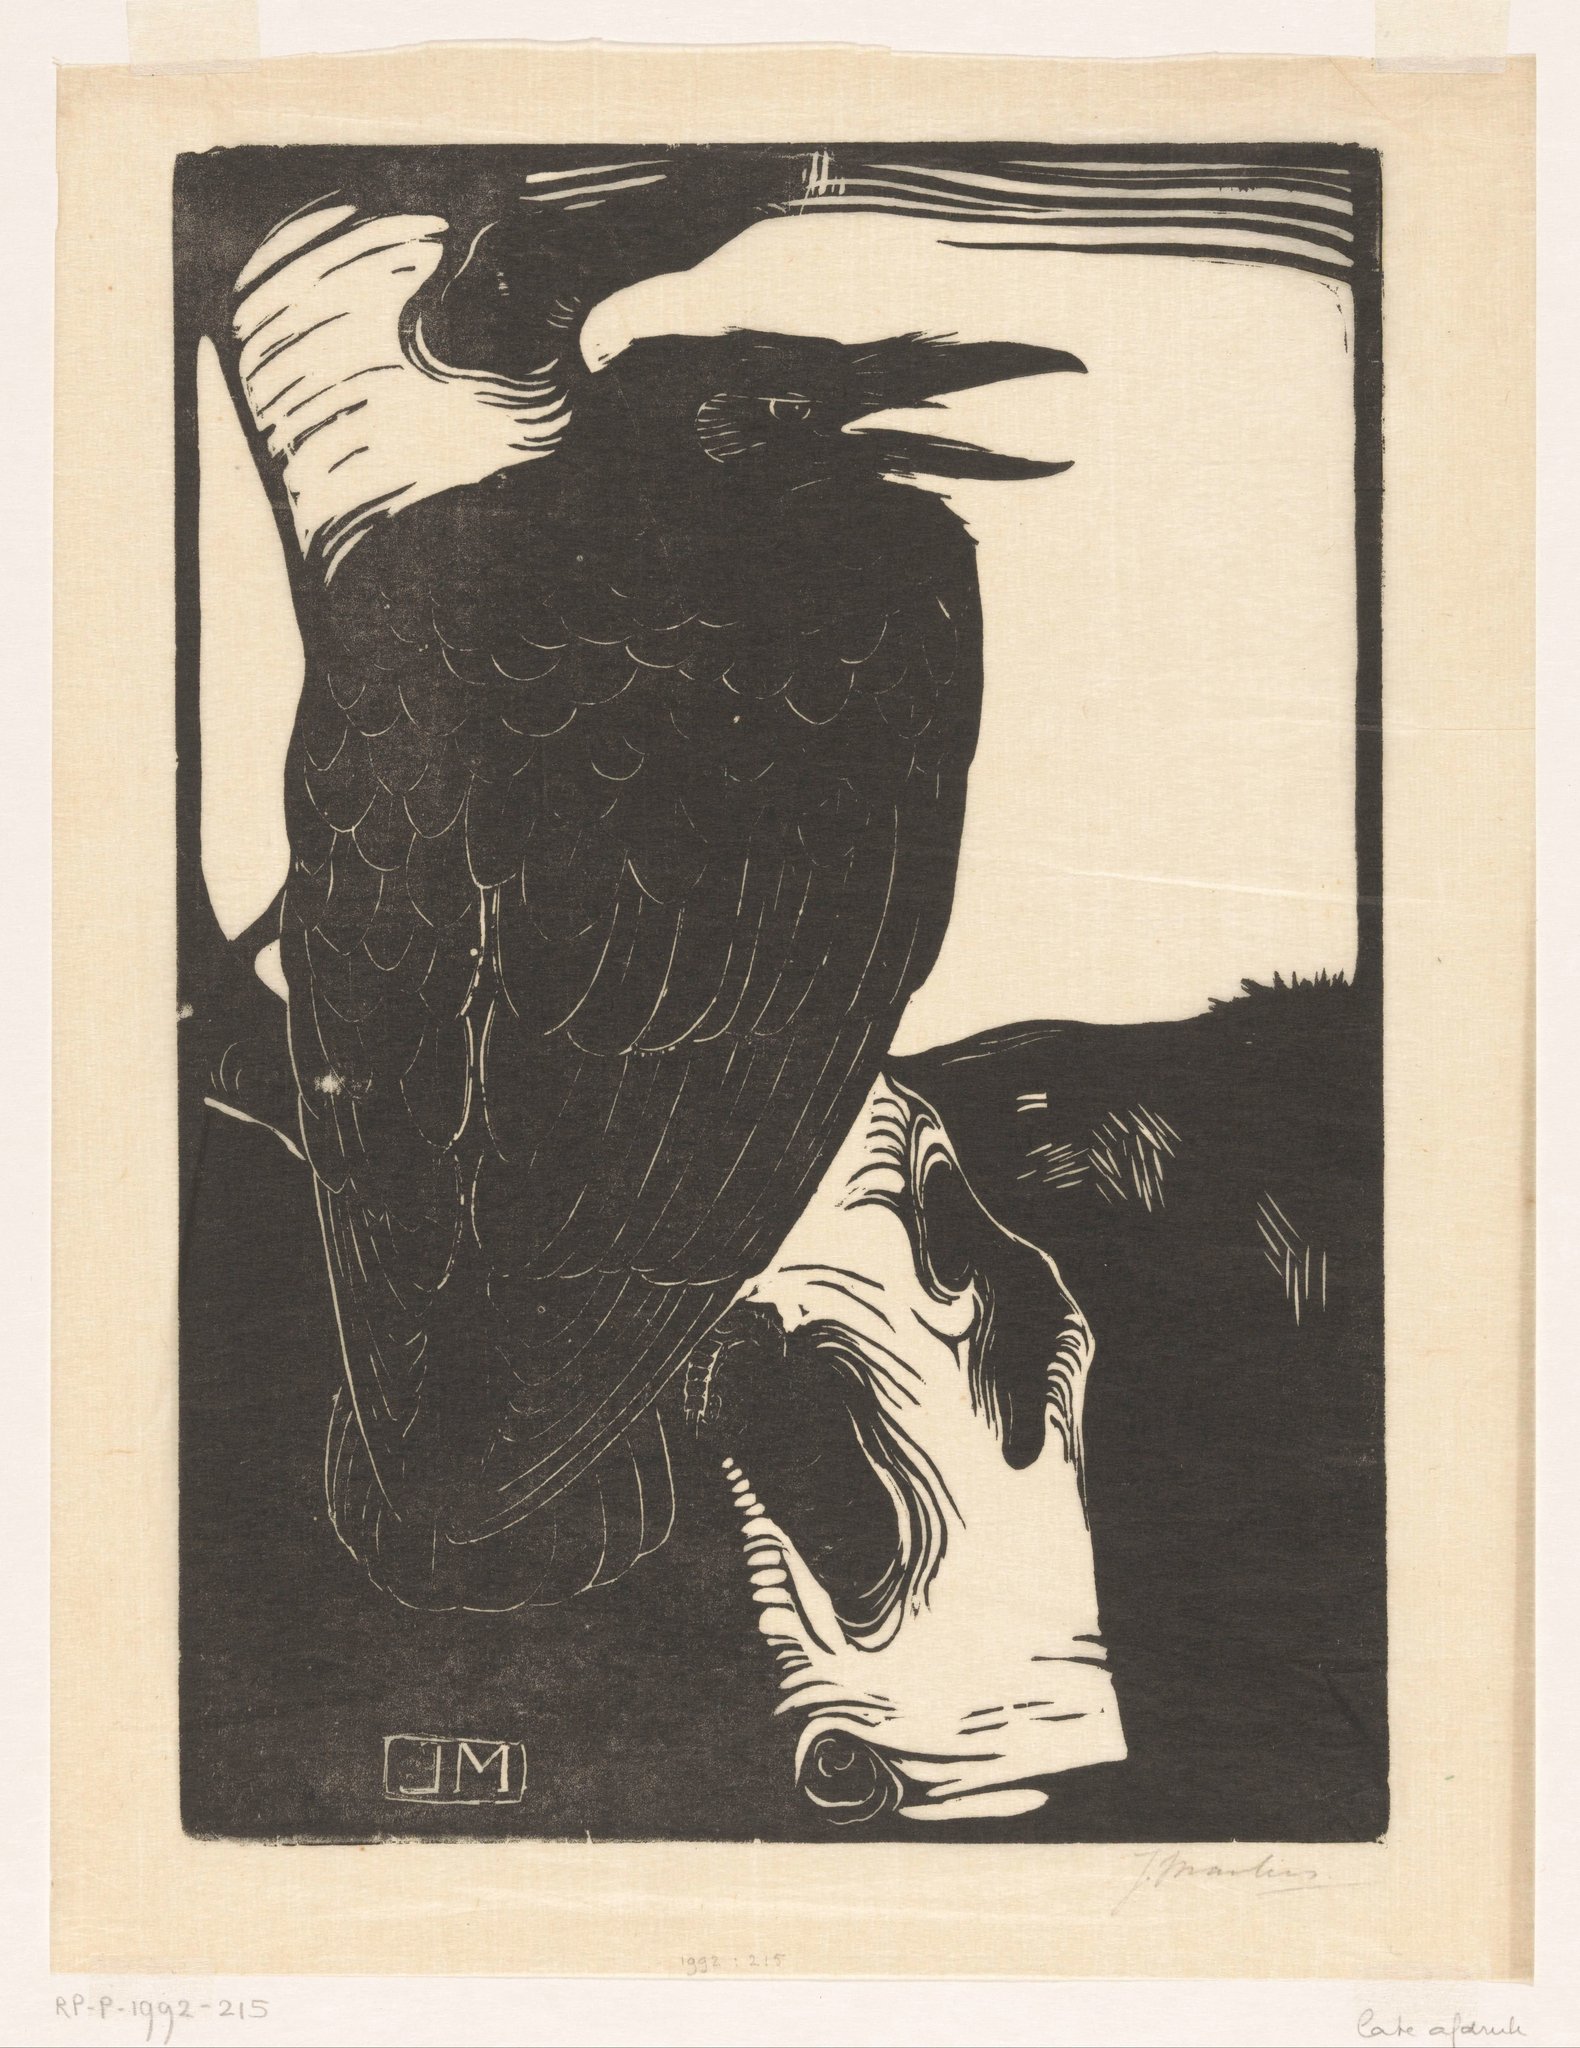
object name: print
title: Raaf op berkenboom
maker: jan mankes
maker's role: draughtsman, painter, print maker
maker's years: 1889-1920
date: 1906-1913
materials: paper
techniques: woodcut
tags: song-birds: raven, trees: birch